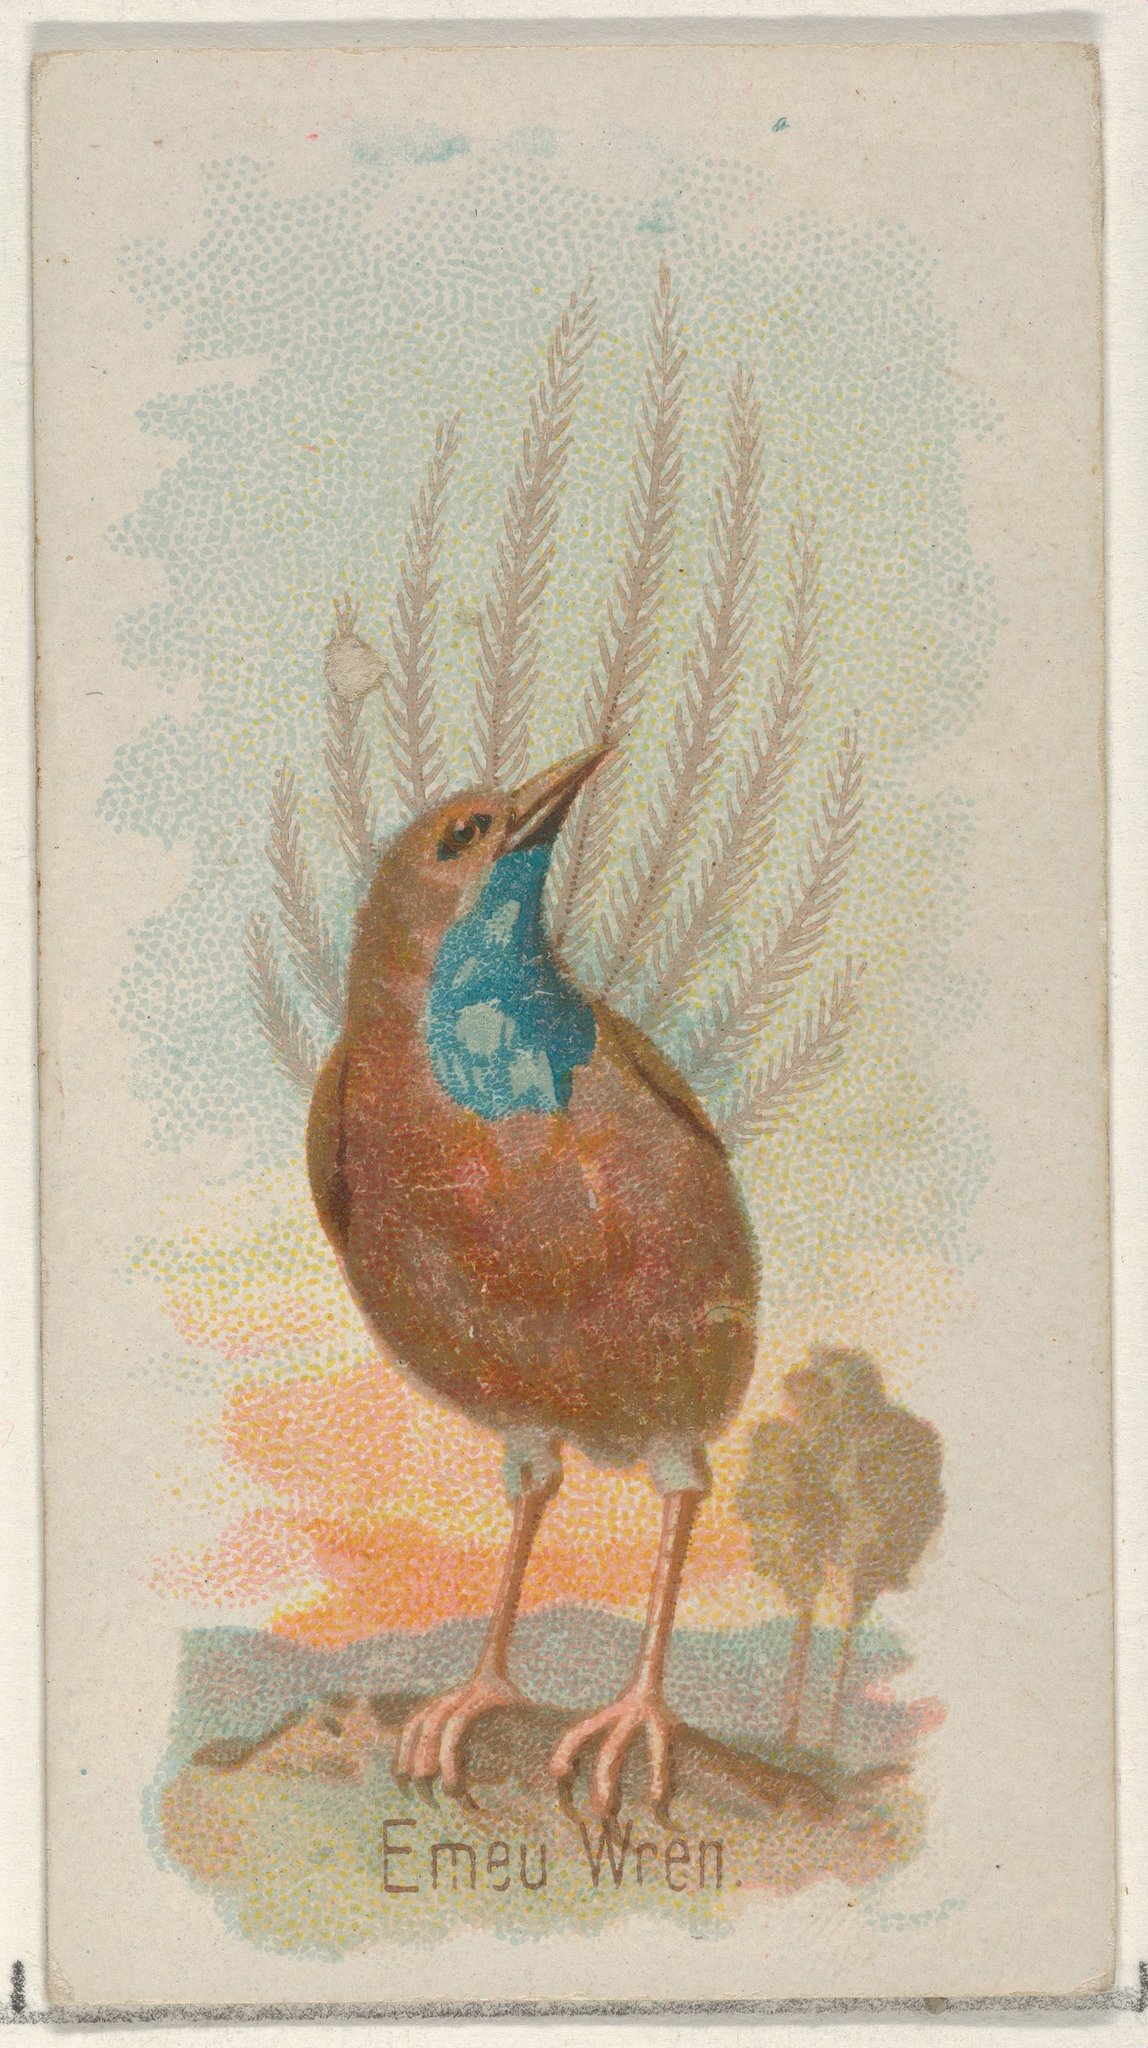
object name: print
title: Emeu Wren, from the Song Birds of the World series (N23) for Allen & Ginter Cigarettes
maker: allen & ginter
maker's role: publisher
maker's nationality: american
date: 1890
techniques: color lithograph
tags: birds